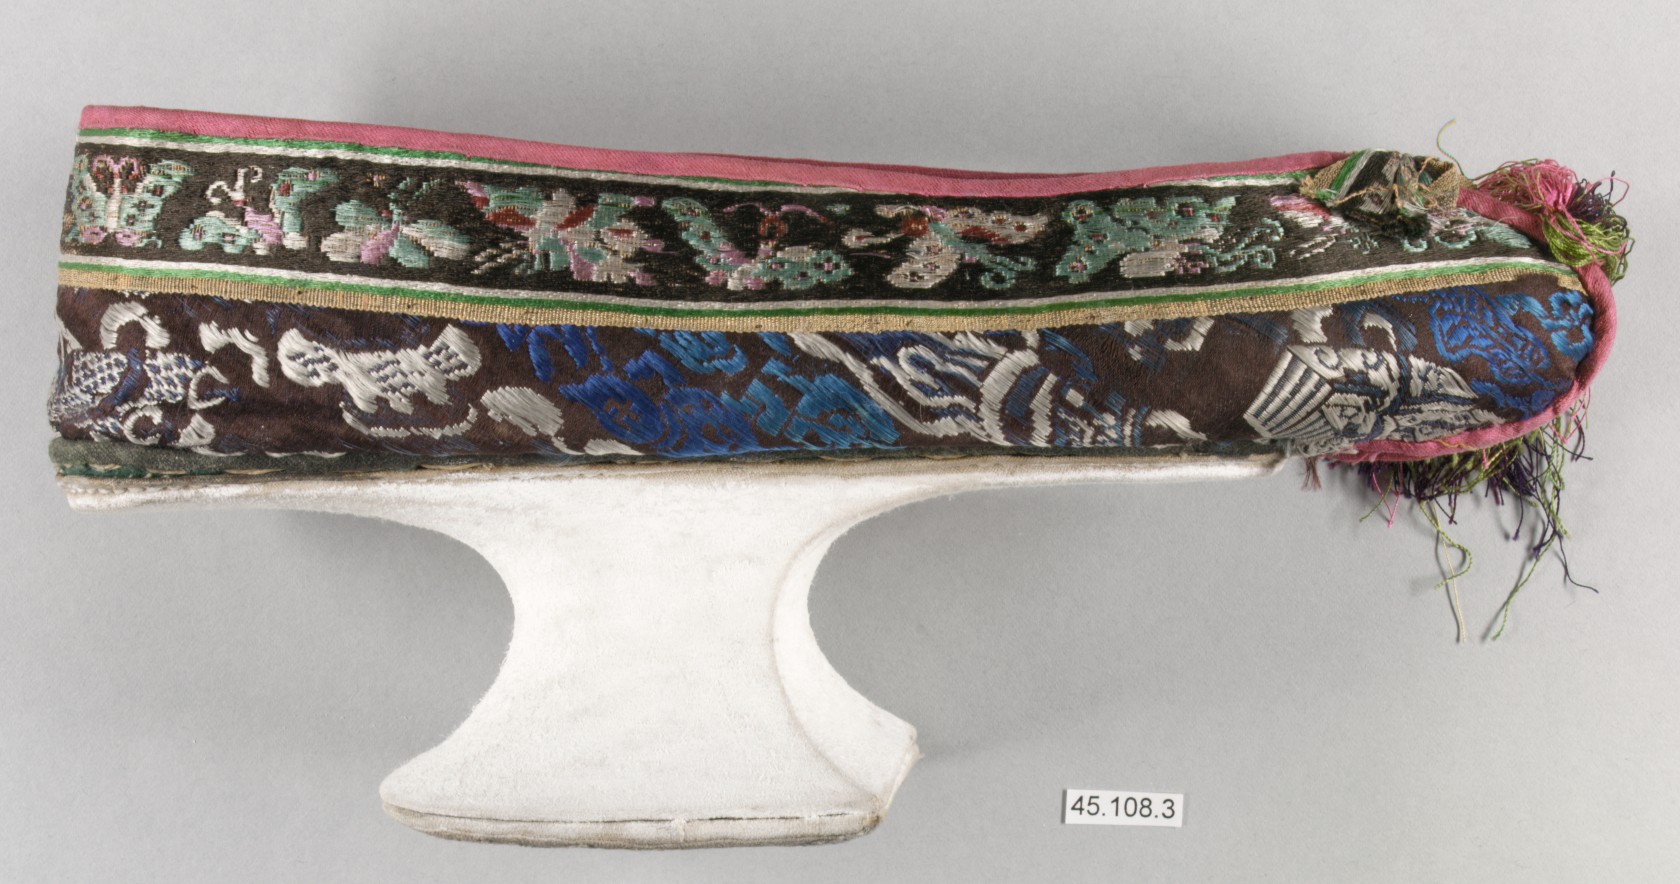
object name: manchu woman's shoe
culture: chinese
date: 1867-1933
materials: silk, wood